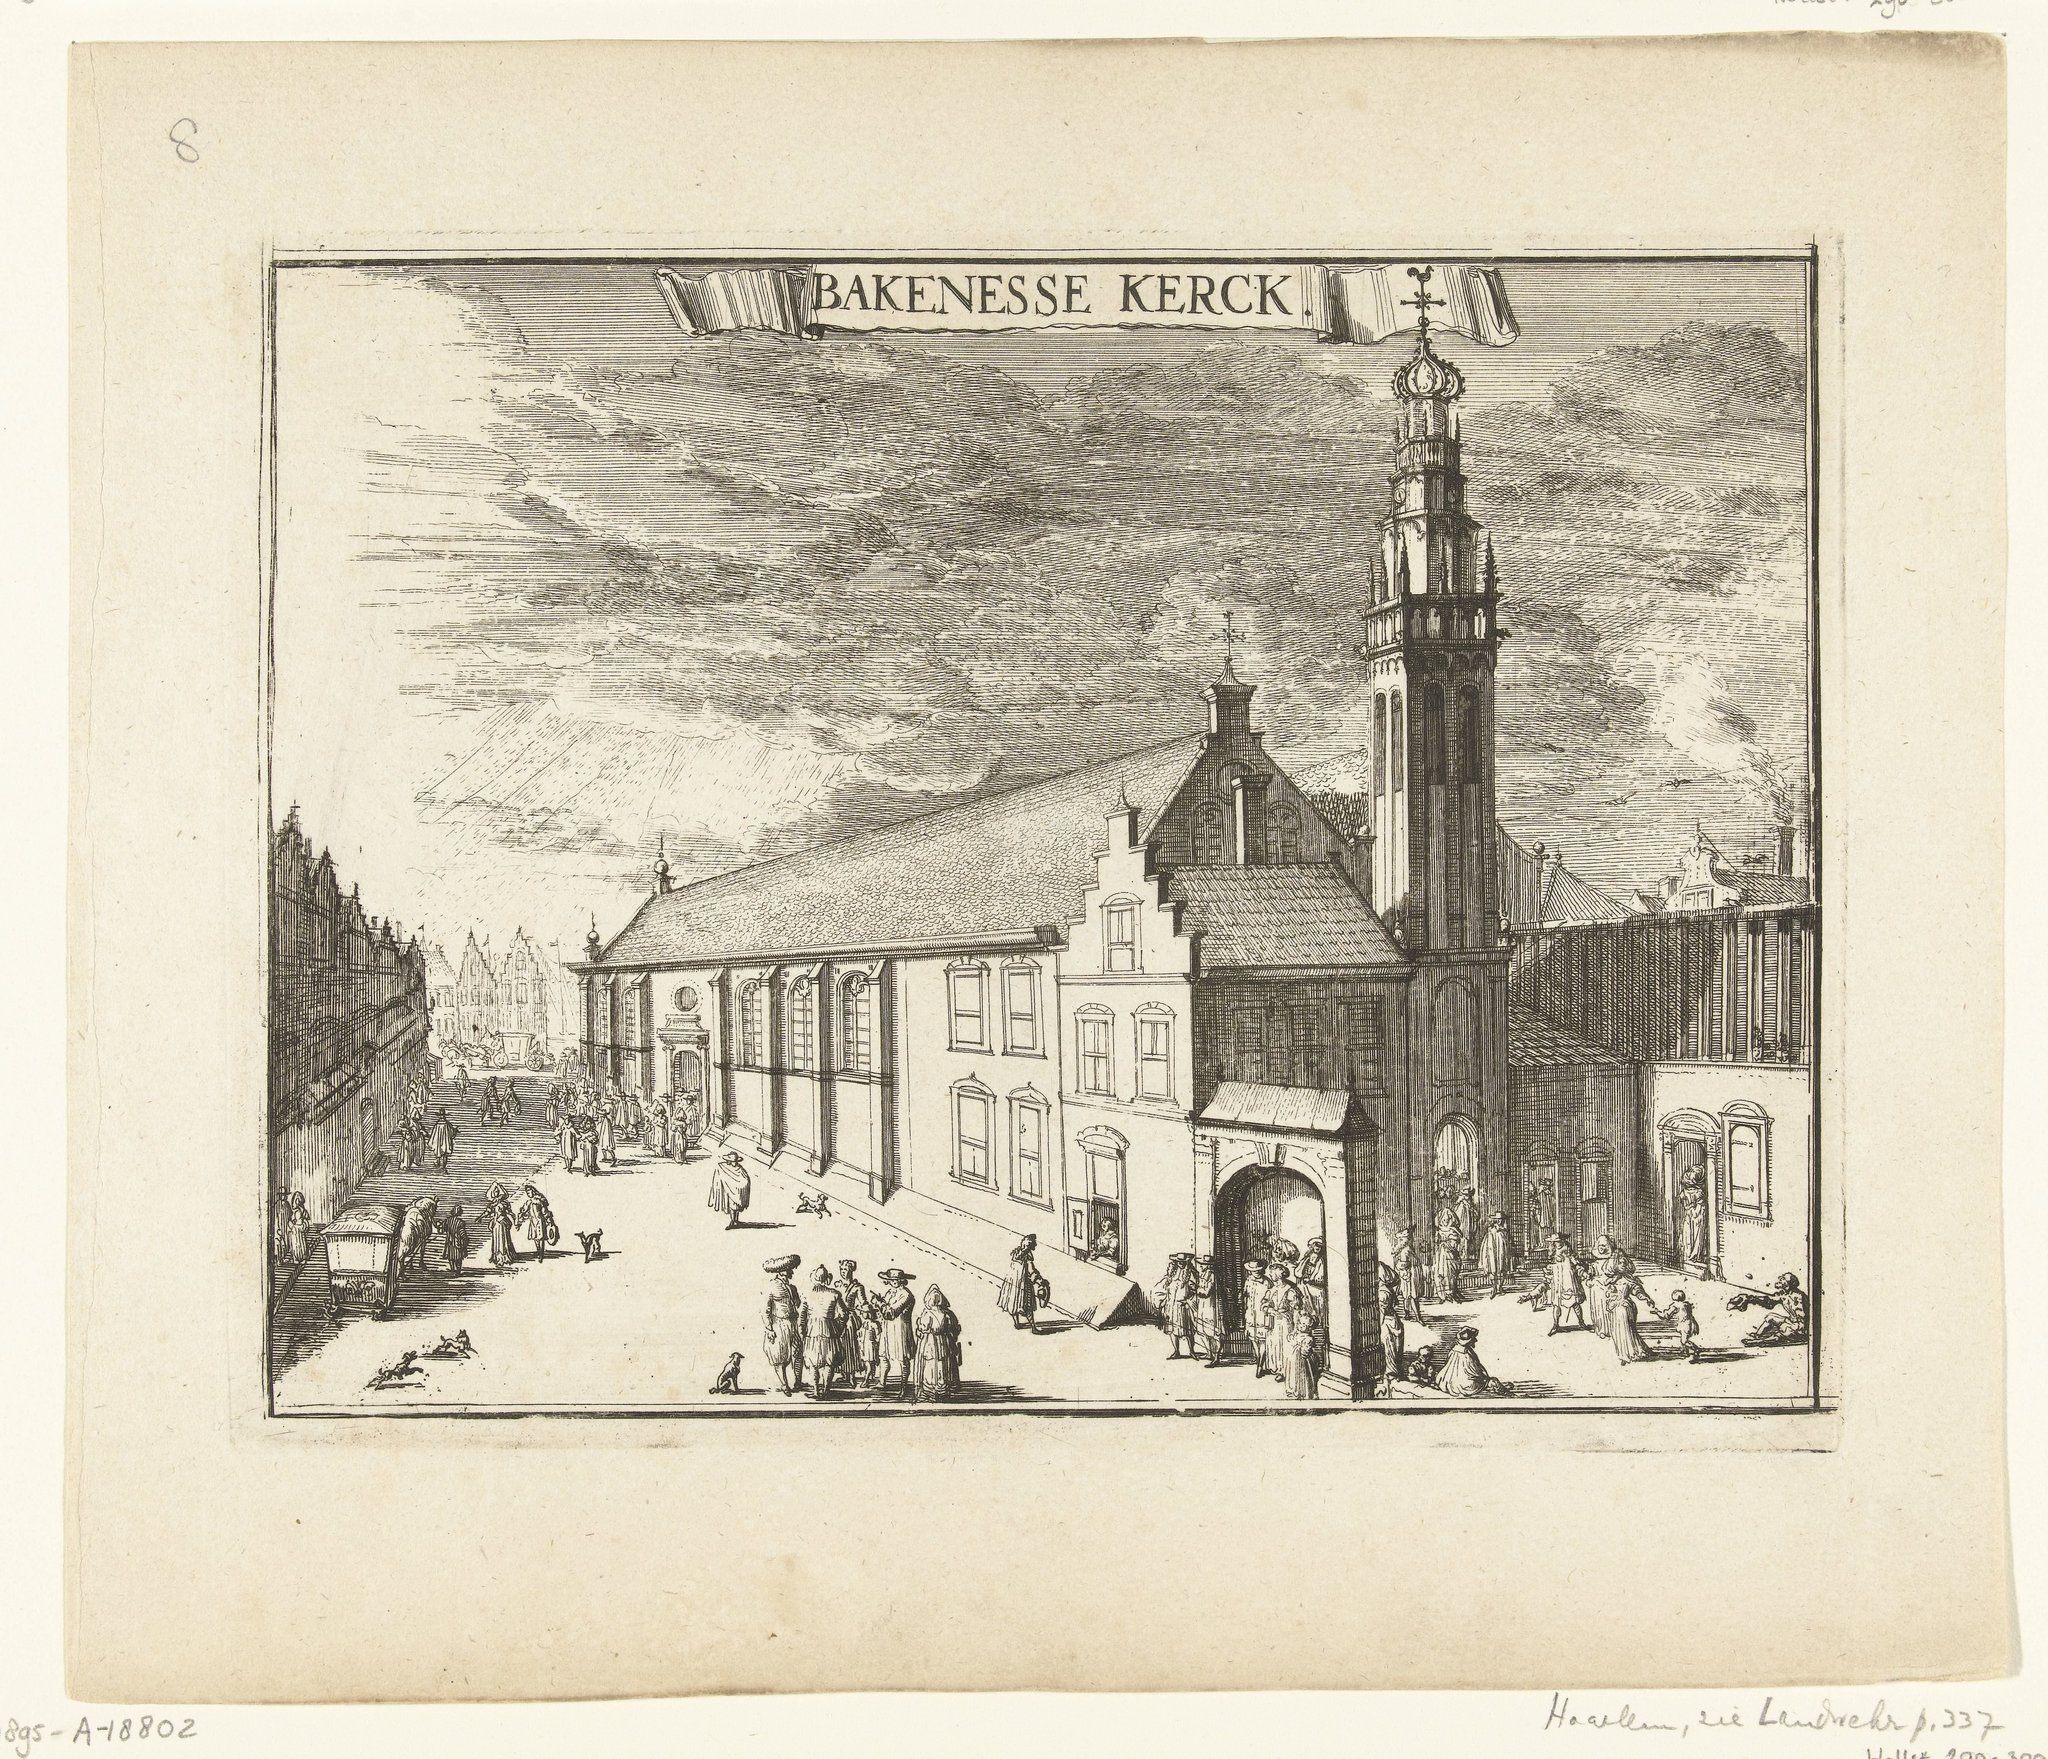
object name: print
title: Plattegrond van Haarlem en gezichten op Haarlem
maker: romeyn de hooghe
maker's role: draughtsman, goldsmith, painter, print maker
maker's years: 1645-1708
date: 1688-1689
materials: paper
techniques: etching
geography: haarlem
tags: church (exterior)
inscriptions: collector's mark: Lugt 2228a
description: Gezicht op de Bakenesserkerk te Haarlem, met vele mensen en enkele koetsen in de straat ernaast en op het plaatsje ervoor. Dit blad maakt deel uit van een omvangrijke prent met een grote plattegrond van Haarlem, omgeven door zeven wapenschilden, een profiel van de stad, gezichten op markante Haarlemse gebouwen en voorstellingen van belangrijke momenten uit de Haarlemse geschiedenis.